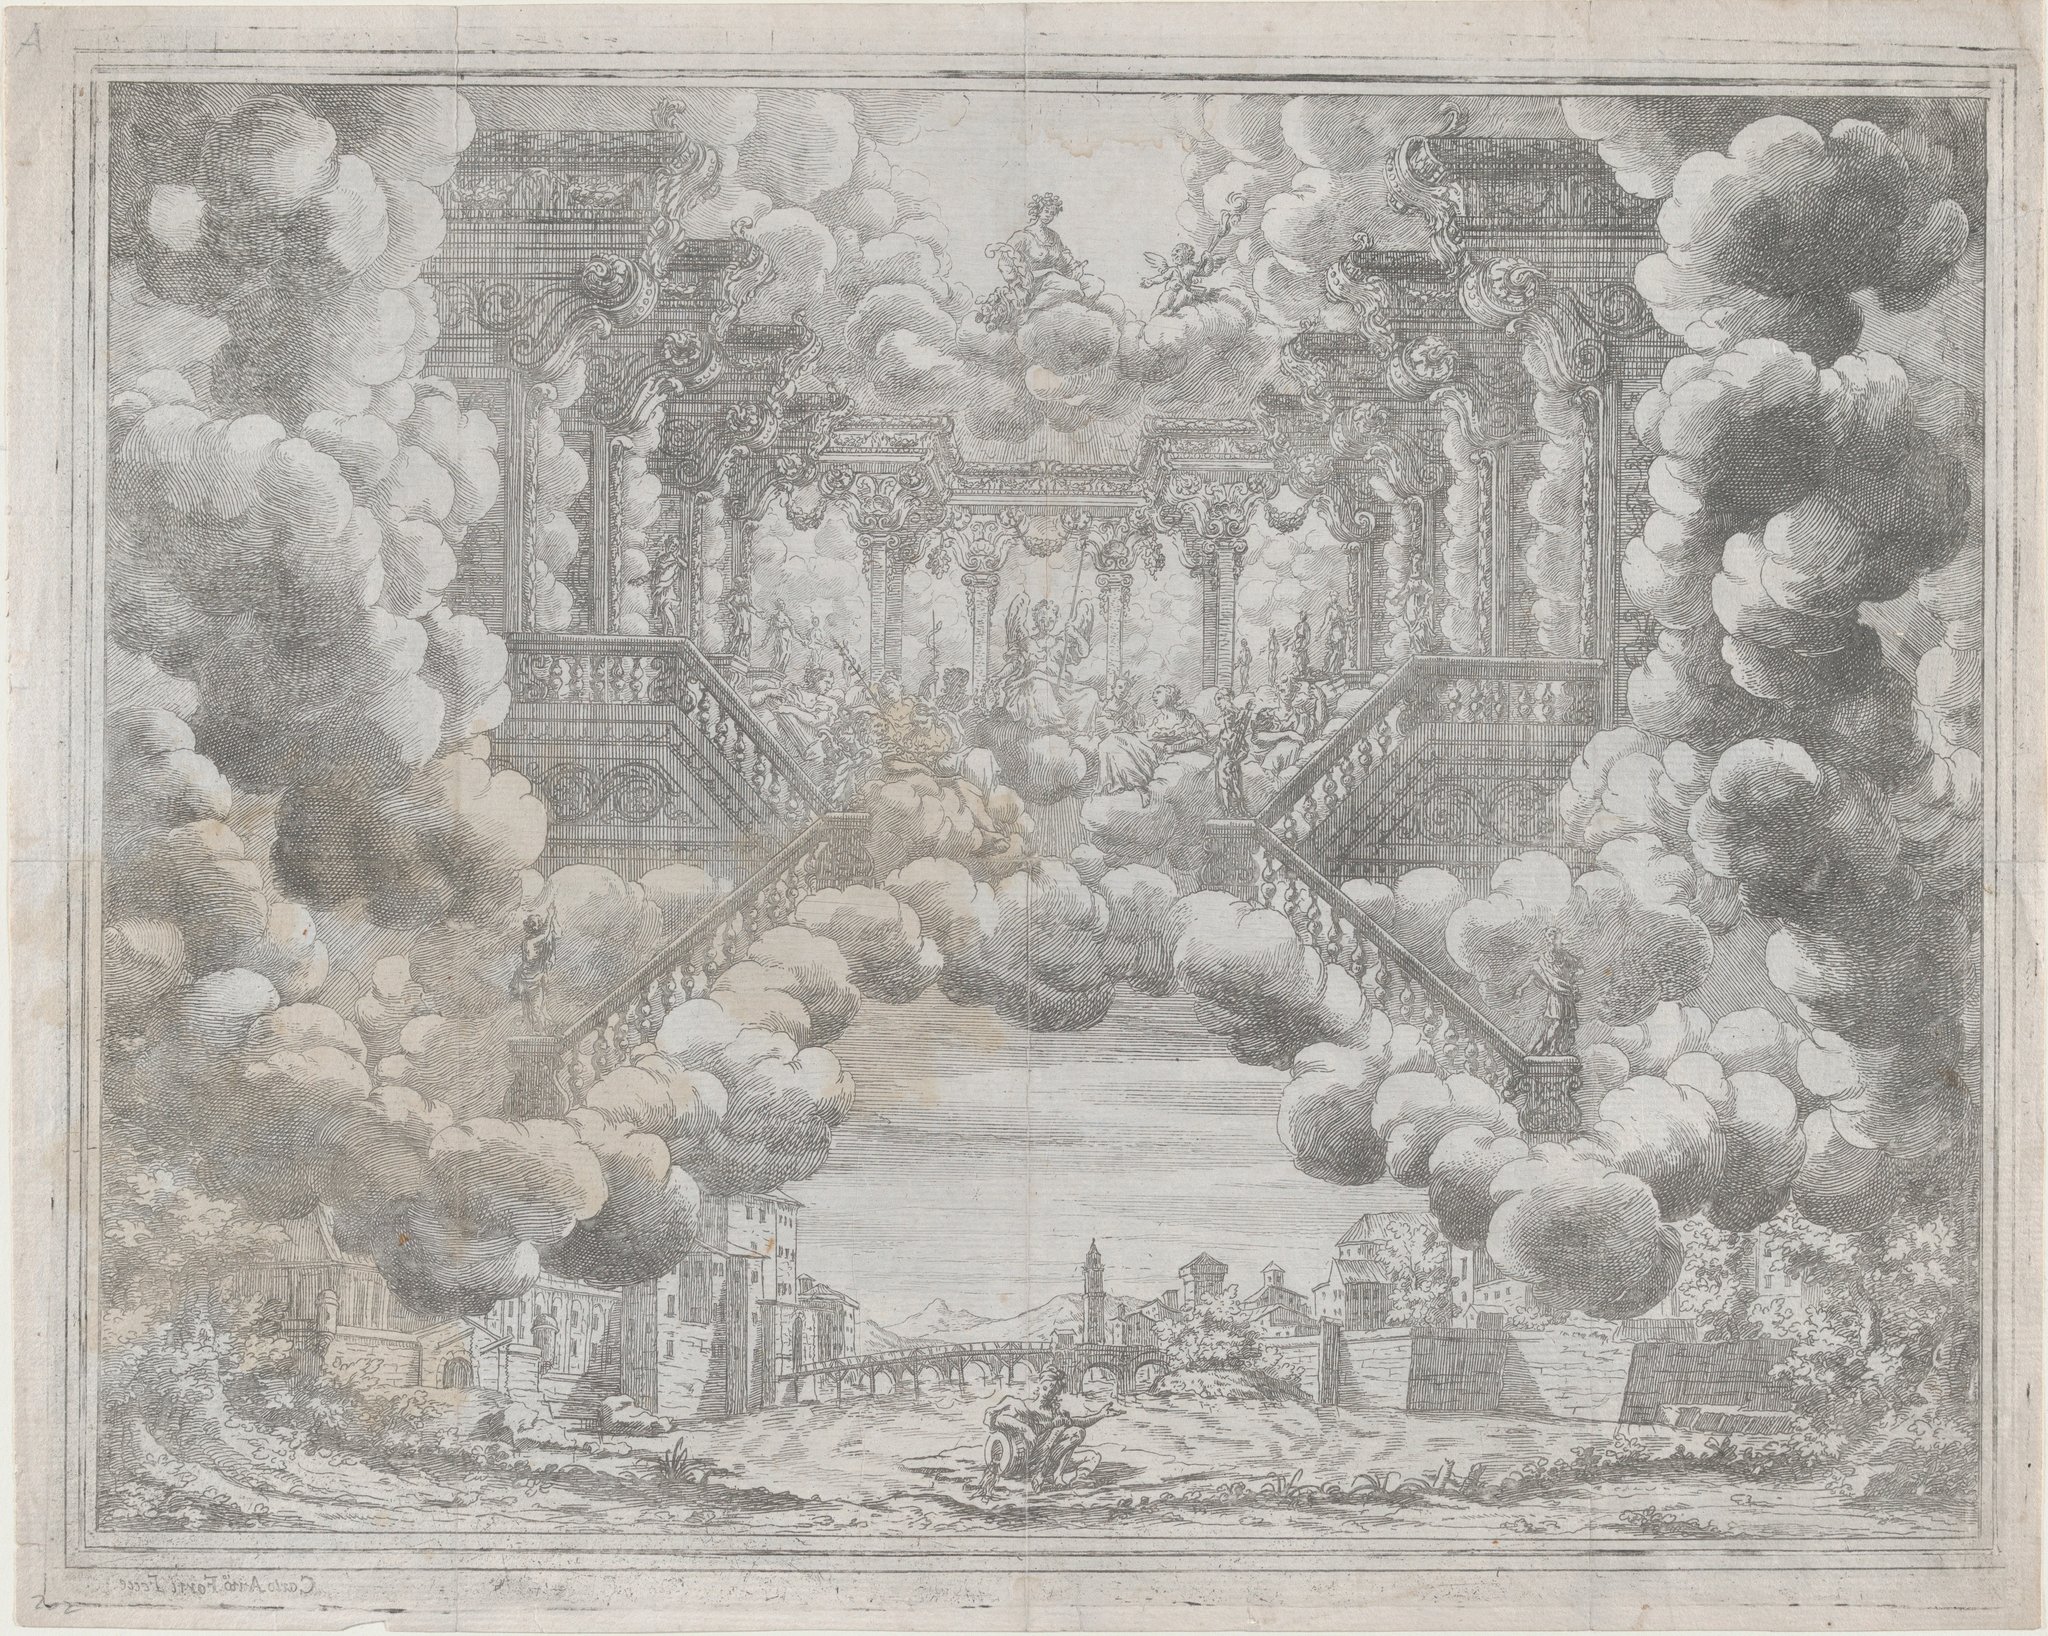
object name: print, fete, ornament architecture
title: Stage design with allegorical figures on a staircase; from 'L'Eta Dell'Oro'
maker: carlo antonio forti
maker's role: artist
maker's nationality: italian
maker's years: 1657-1732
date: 1690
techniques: etching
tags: stairs,stage design